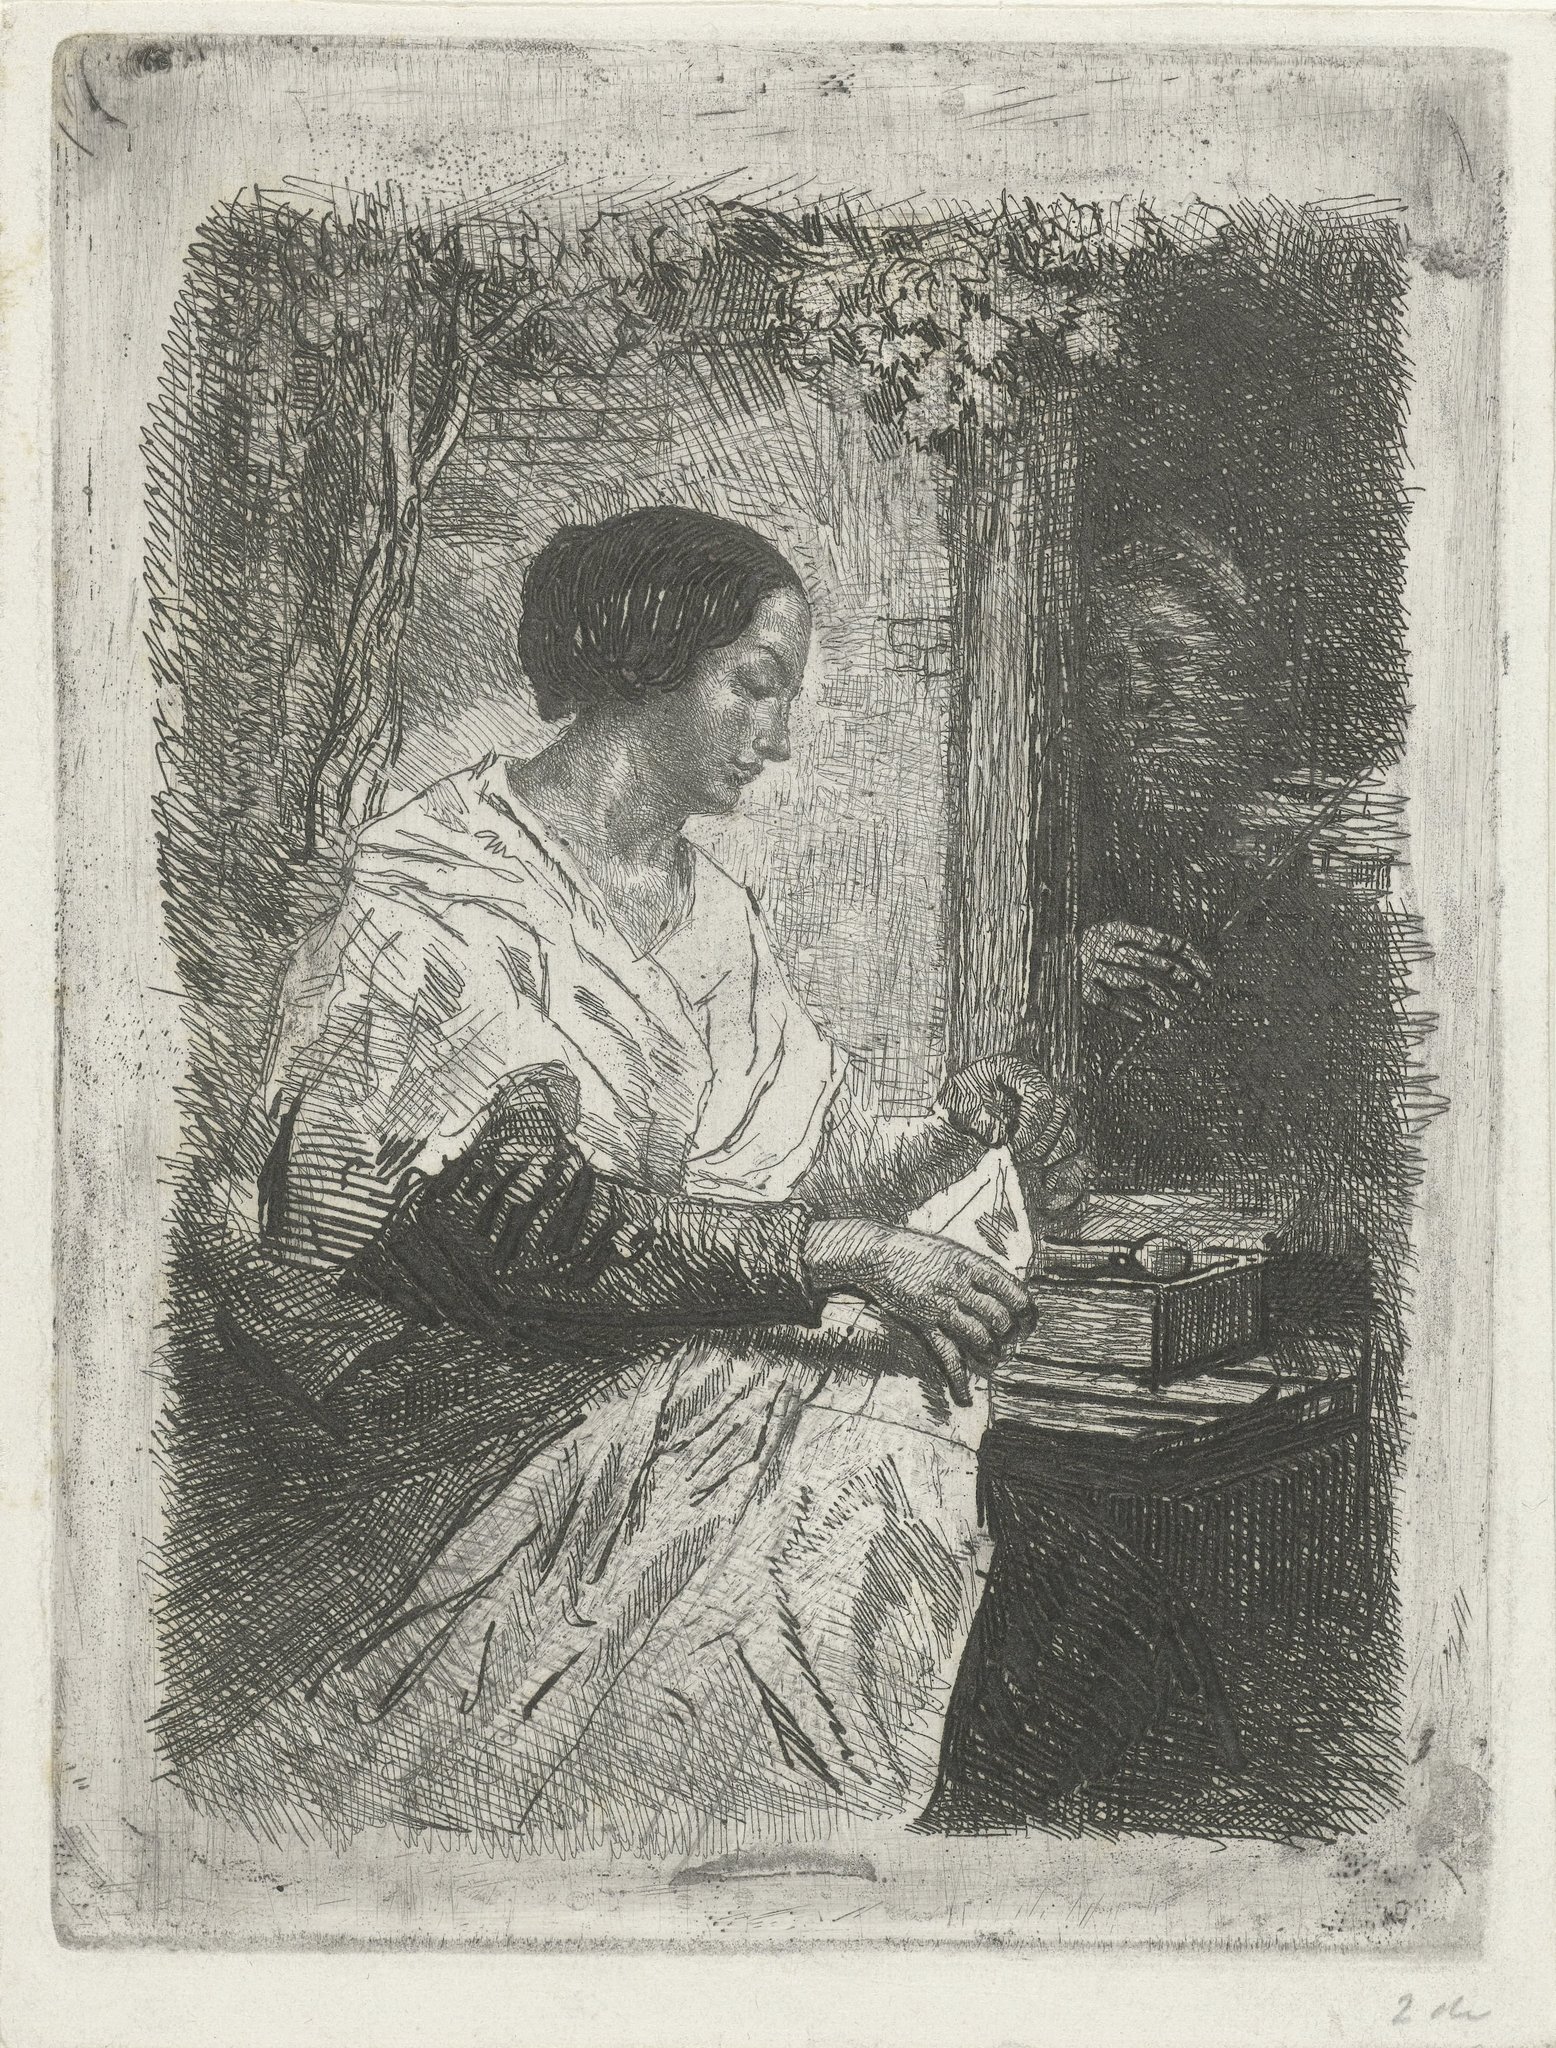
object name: print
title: Naaister en vioolspeler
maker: reinier craeyvanger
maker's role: draughtsman, print maker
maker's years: 1812-1880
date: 1822-1880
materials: paper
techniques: etching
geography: amsterdam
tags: one person playing string instrument (bowed), violin, fiddle, home sewing; repair of clothes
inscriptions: collector's mark: Lugt 2228, collector's mark: Lugt 2166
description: Een vrouw zit op een bankje en gebruikt naald en draad om een laken te verstellen. In de deuropening achter haar speelt een oude man viool.